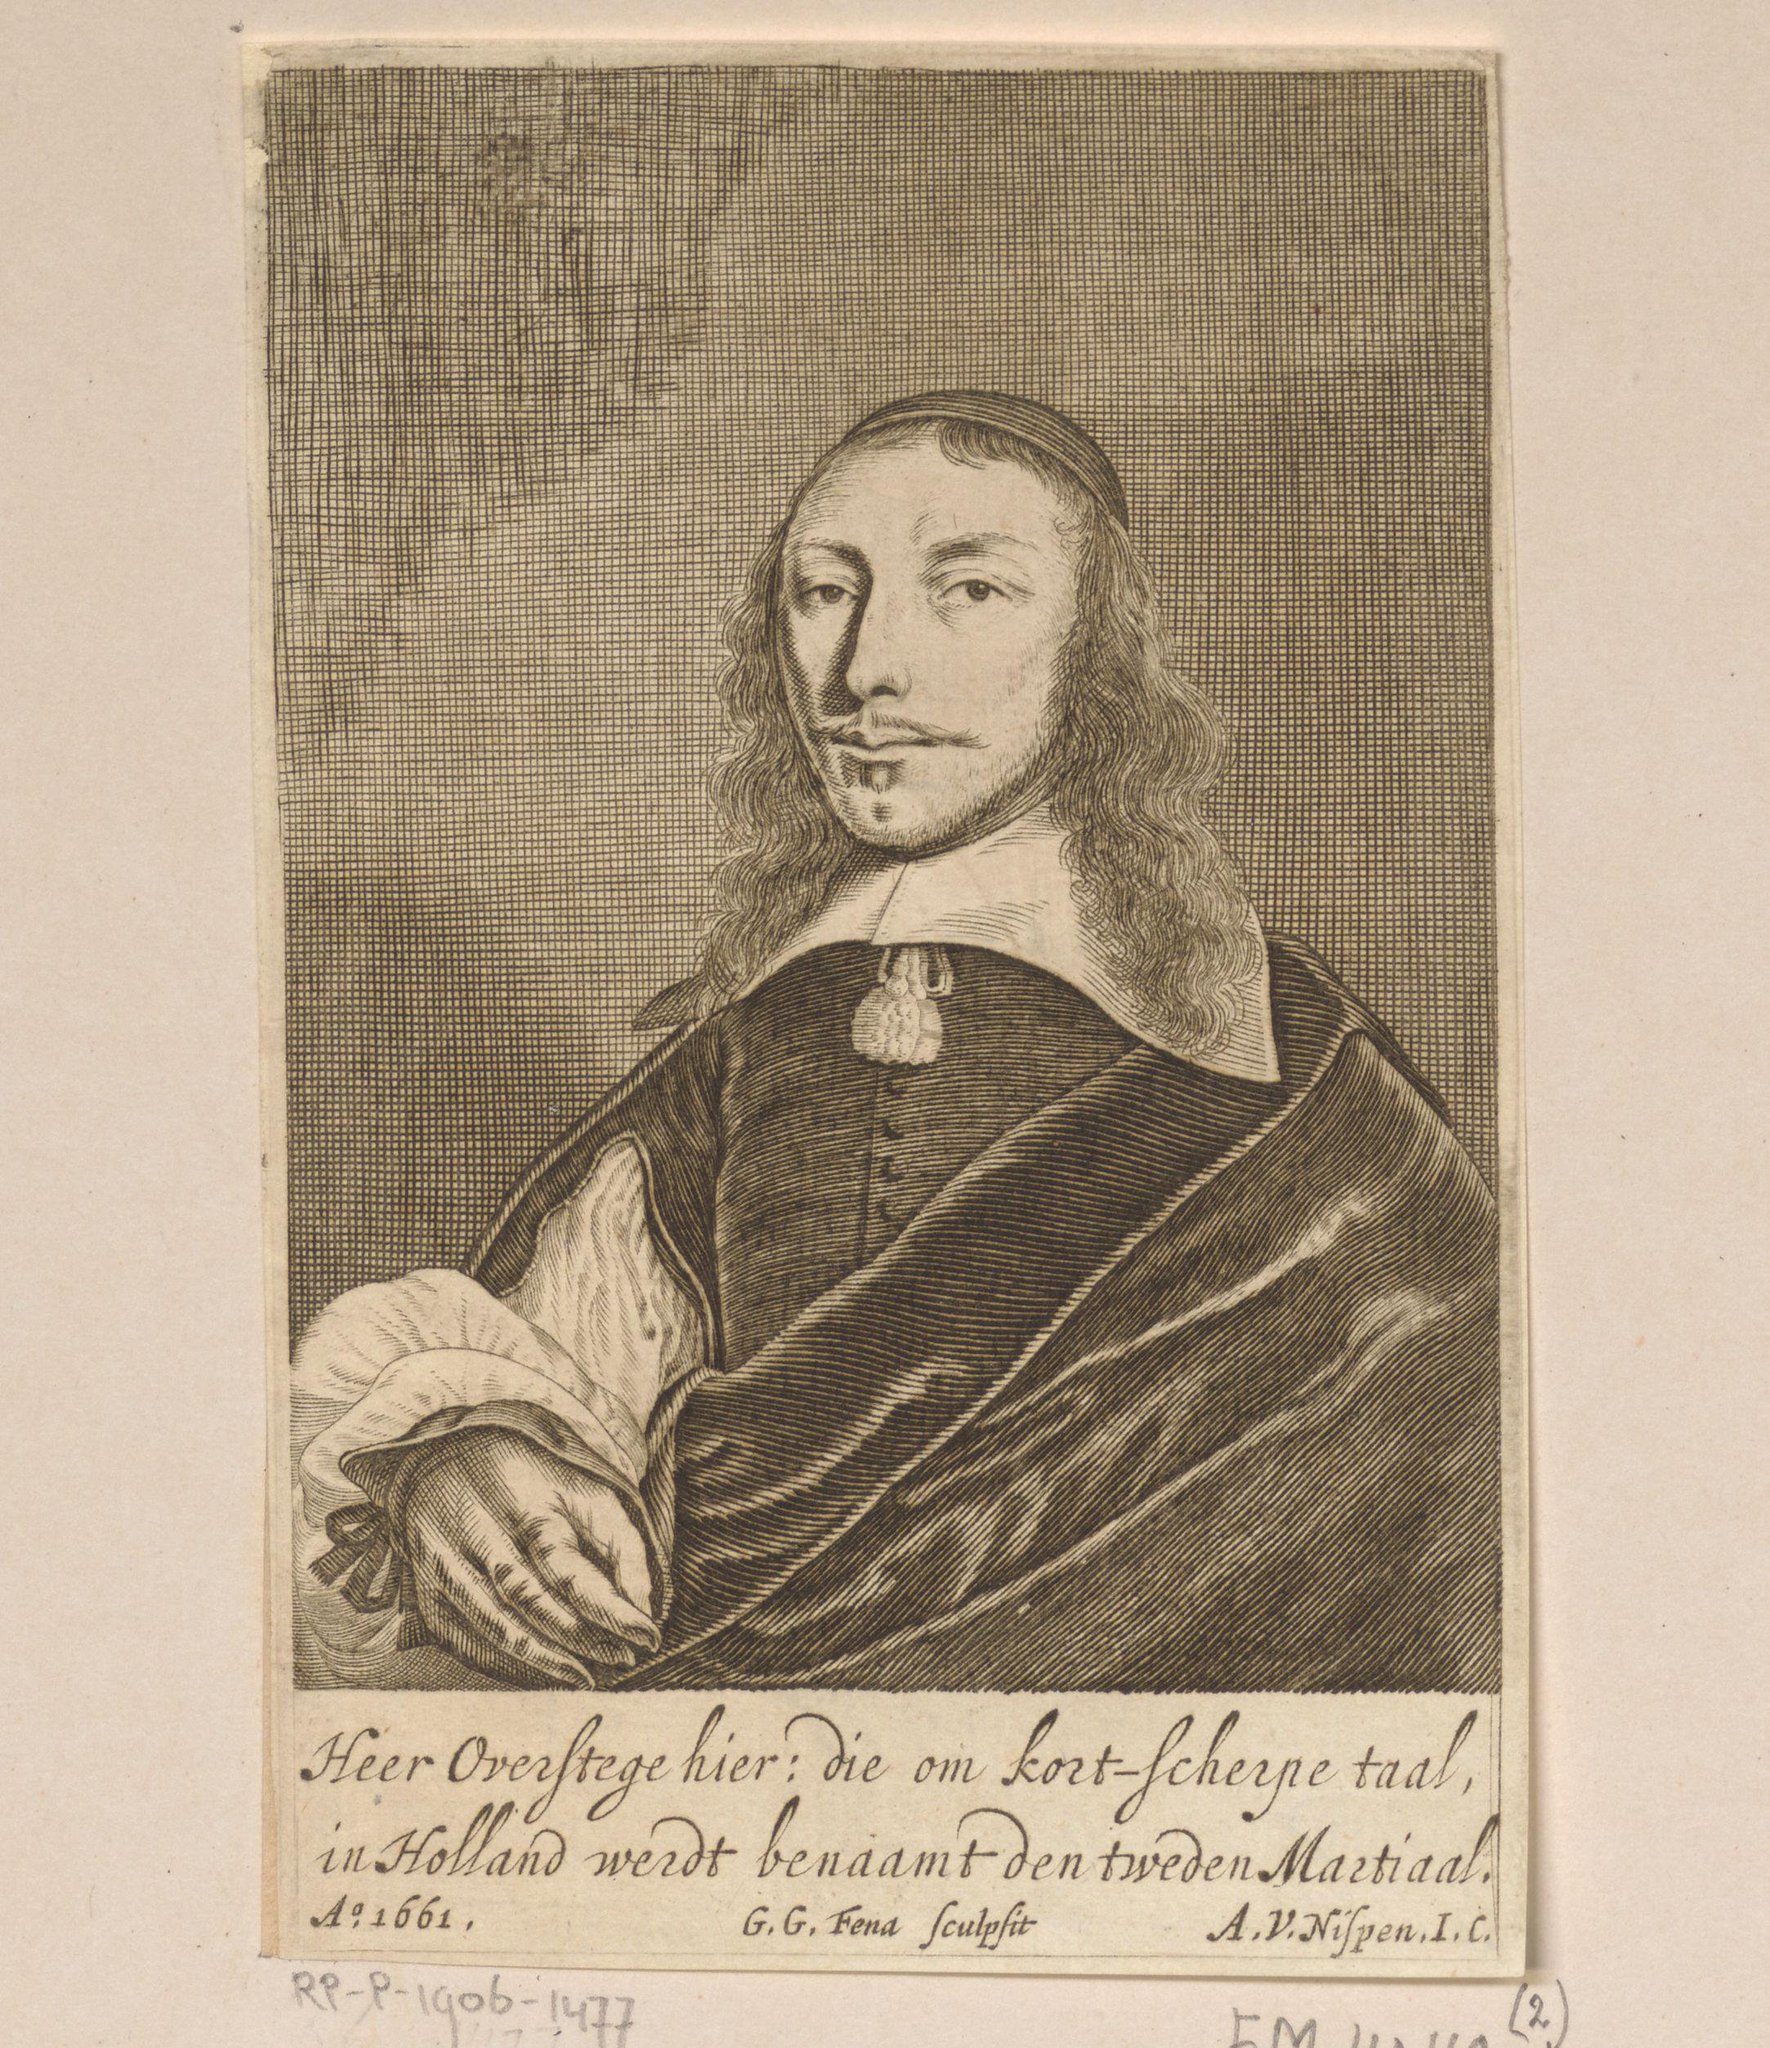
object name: print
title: Portret van Cornelis van Overstege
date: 1661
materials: paper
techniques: engraving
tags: netherlands, dordrecht, historical persons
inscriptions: collector's mark: Lugt 2228